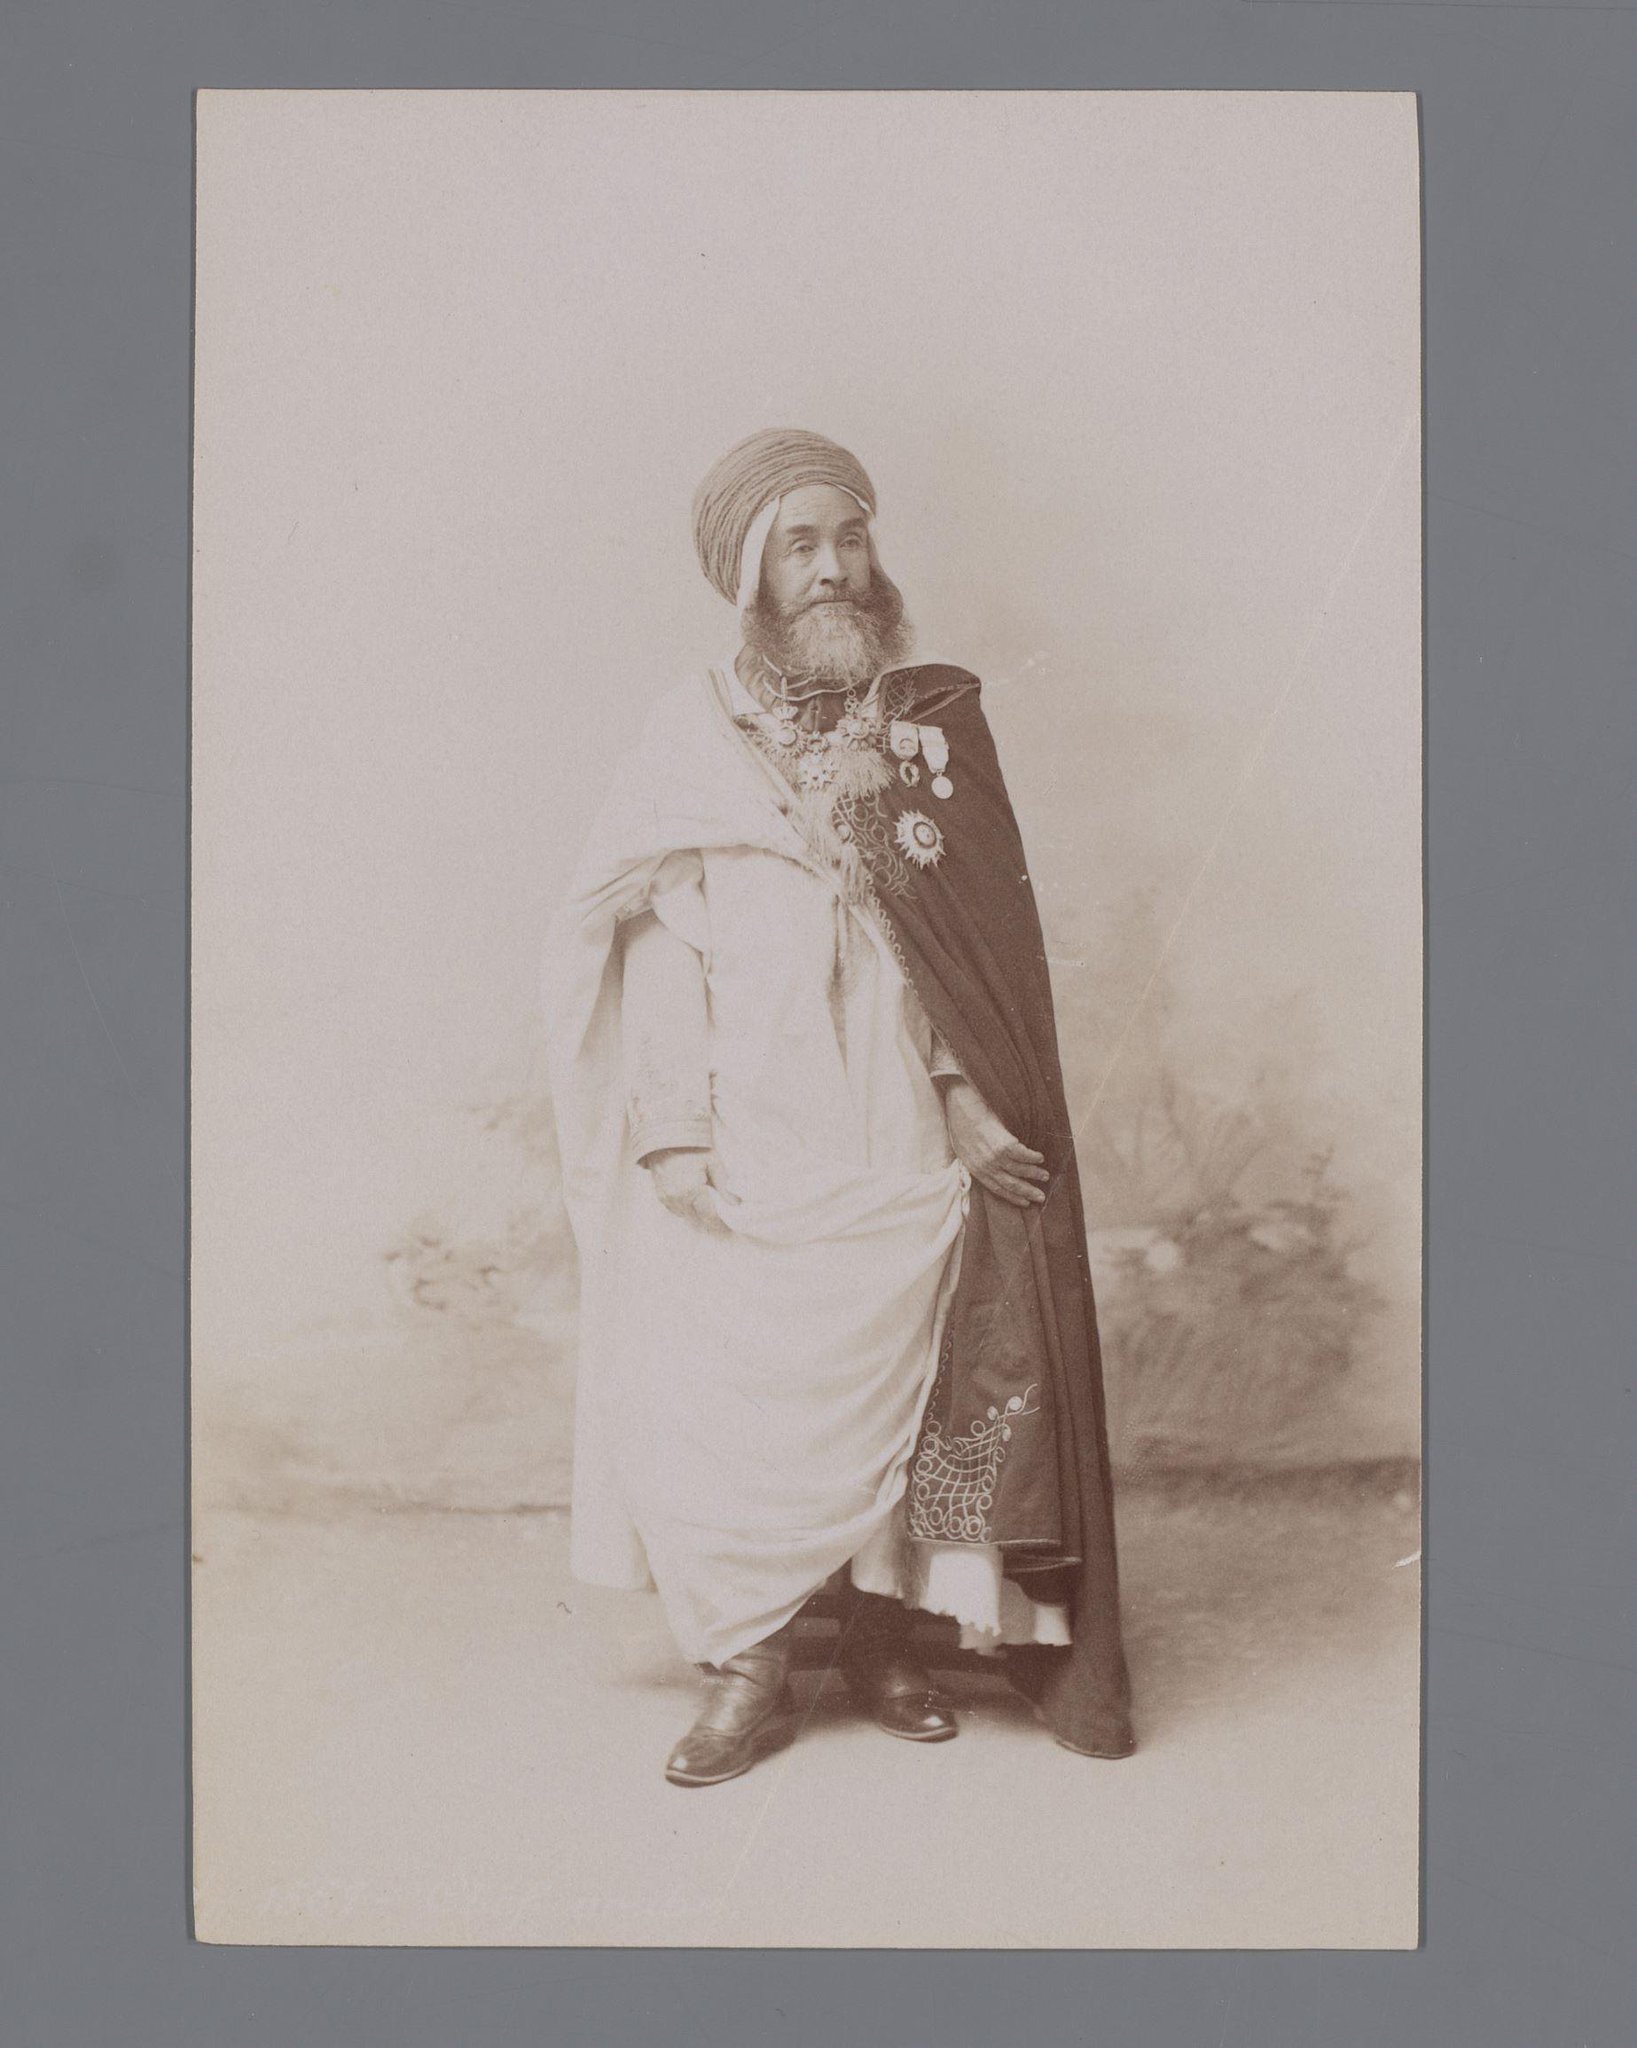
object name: photograph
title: Portret van een onbekende Algerijnse man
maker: Anonymous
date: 1860-1900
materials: paper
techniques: albumen print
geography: algeria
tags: adult man, anonymous historical person portrayed